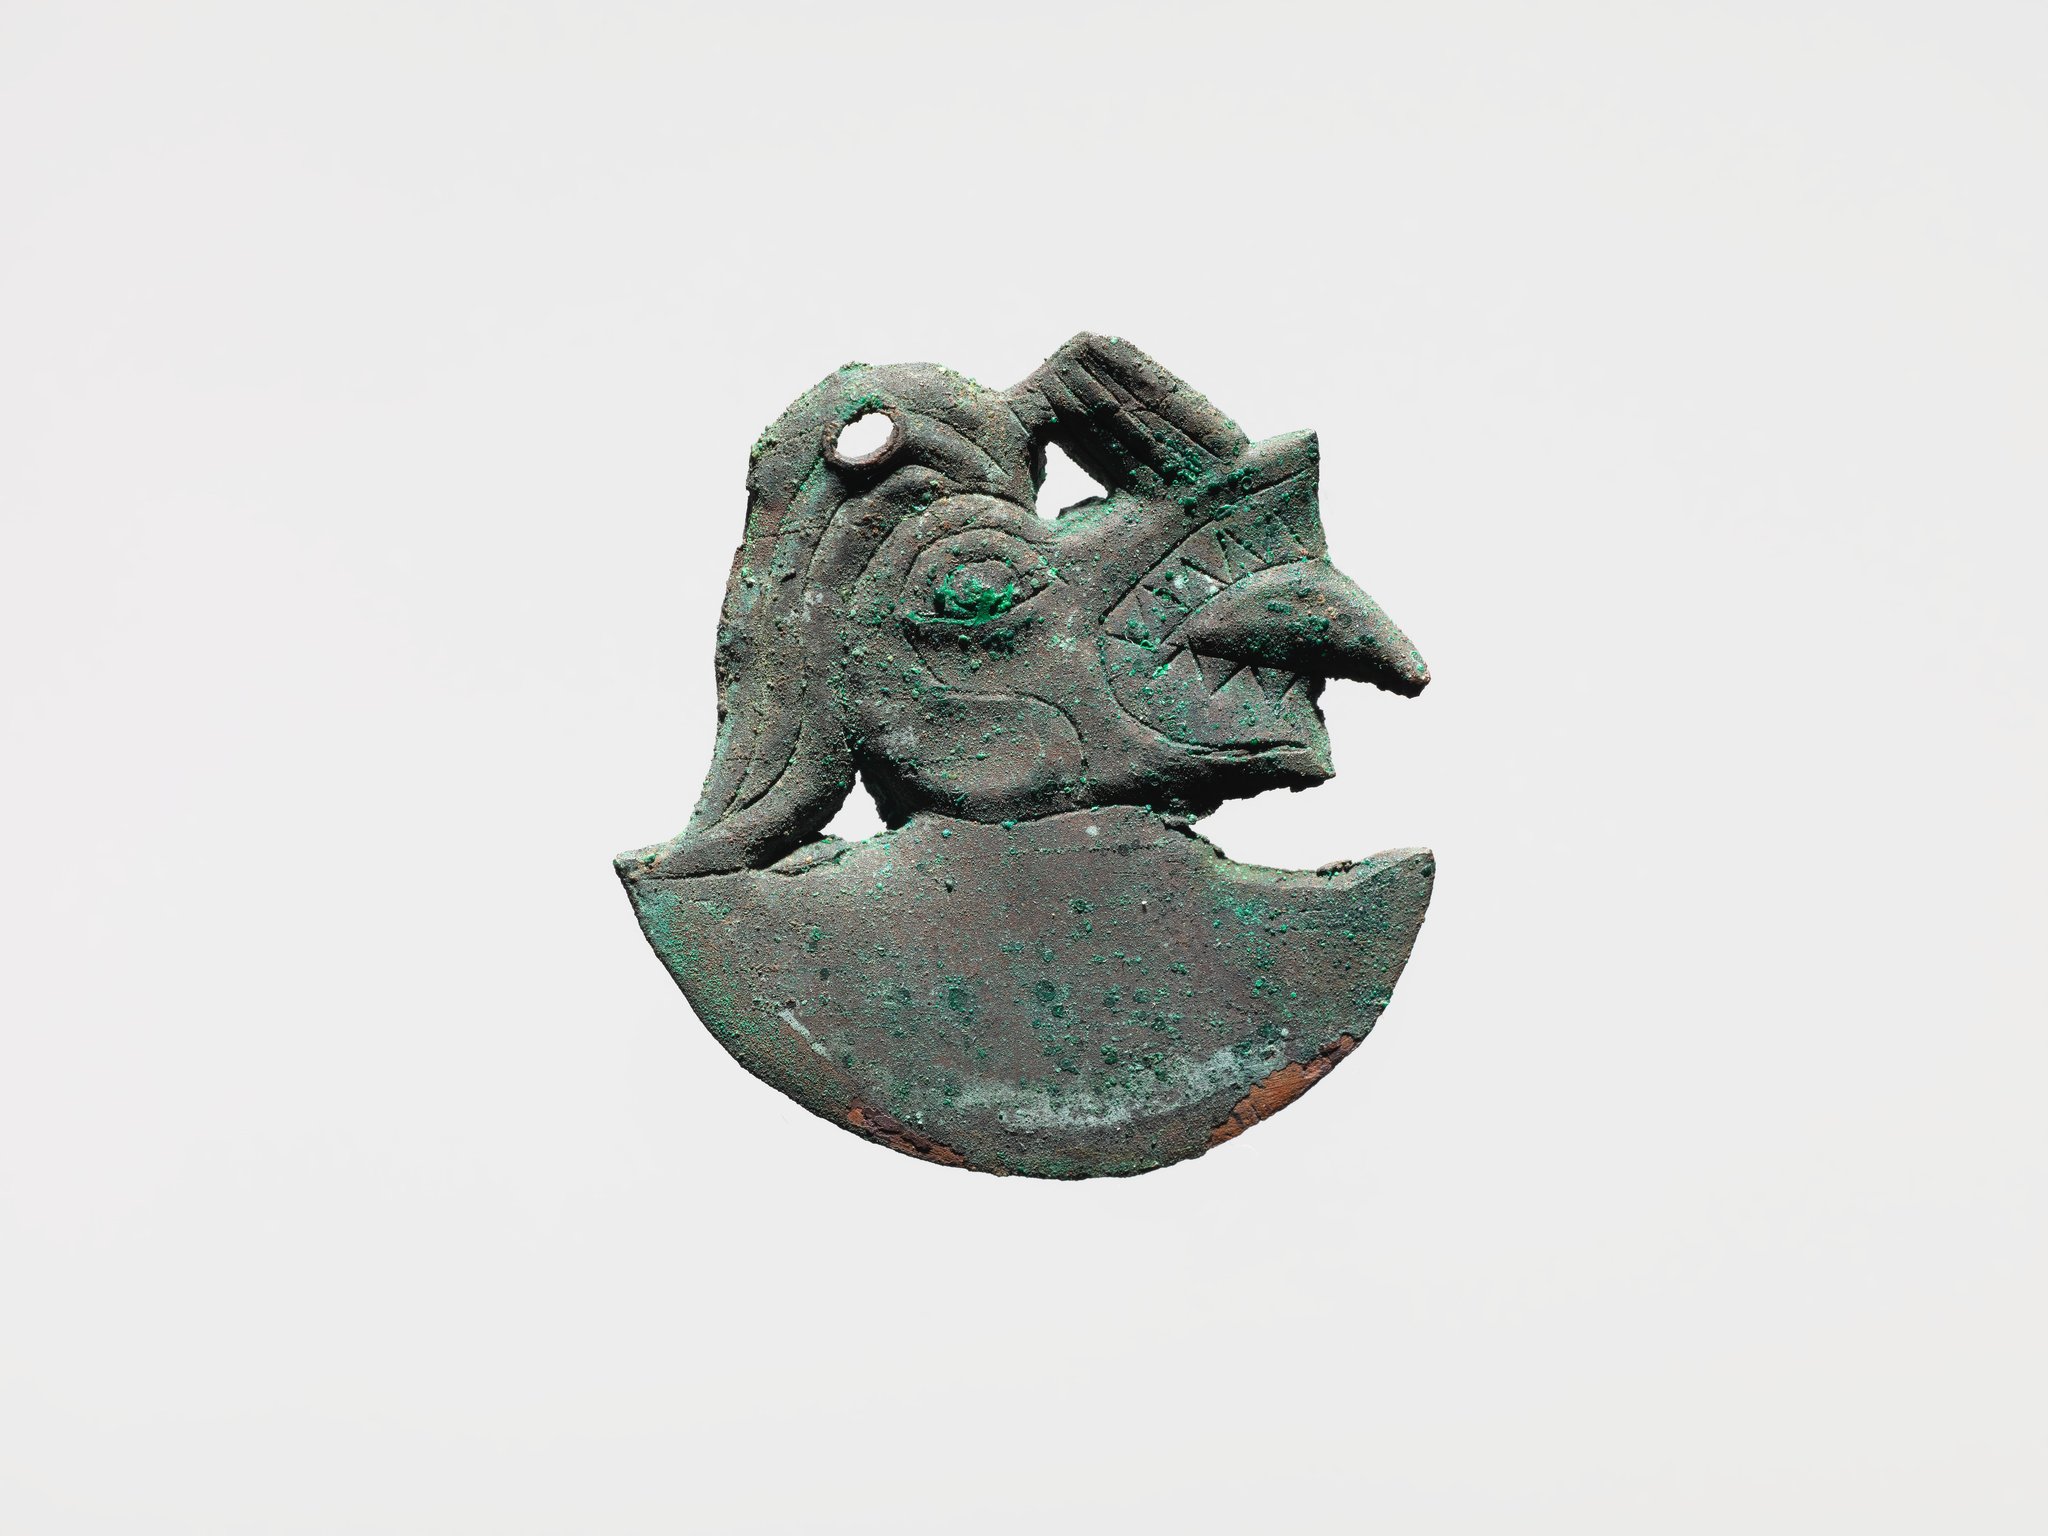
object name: ornament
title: Crescent Ornaments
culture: moche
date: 501-700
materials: copper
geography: peru